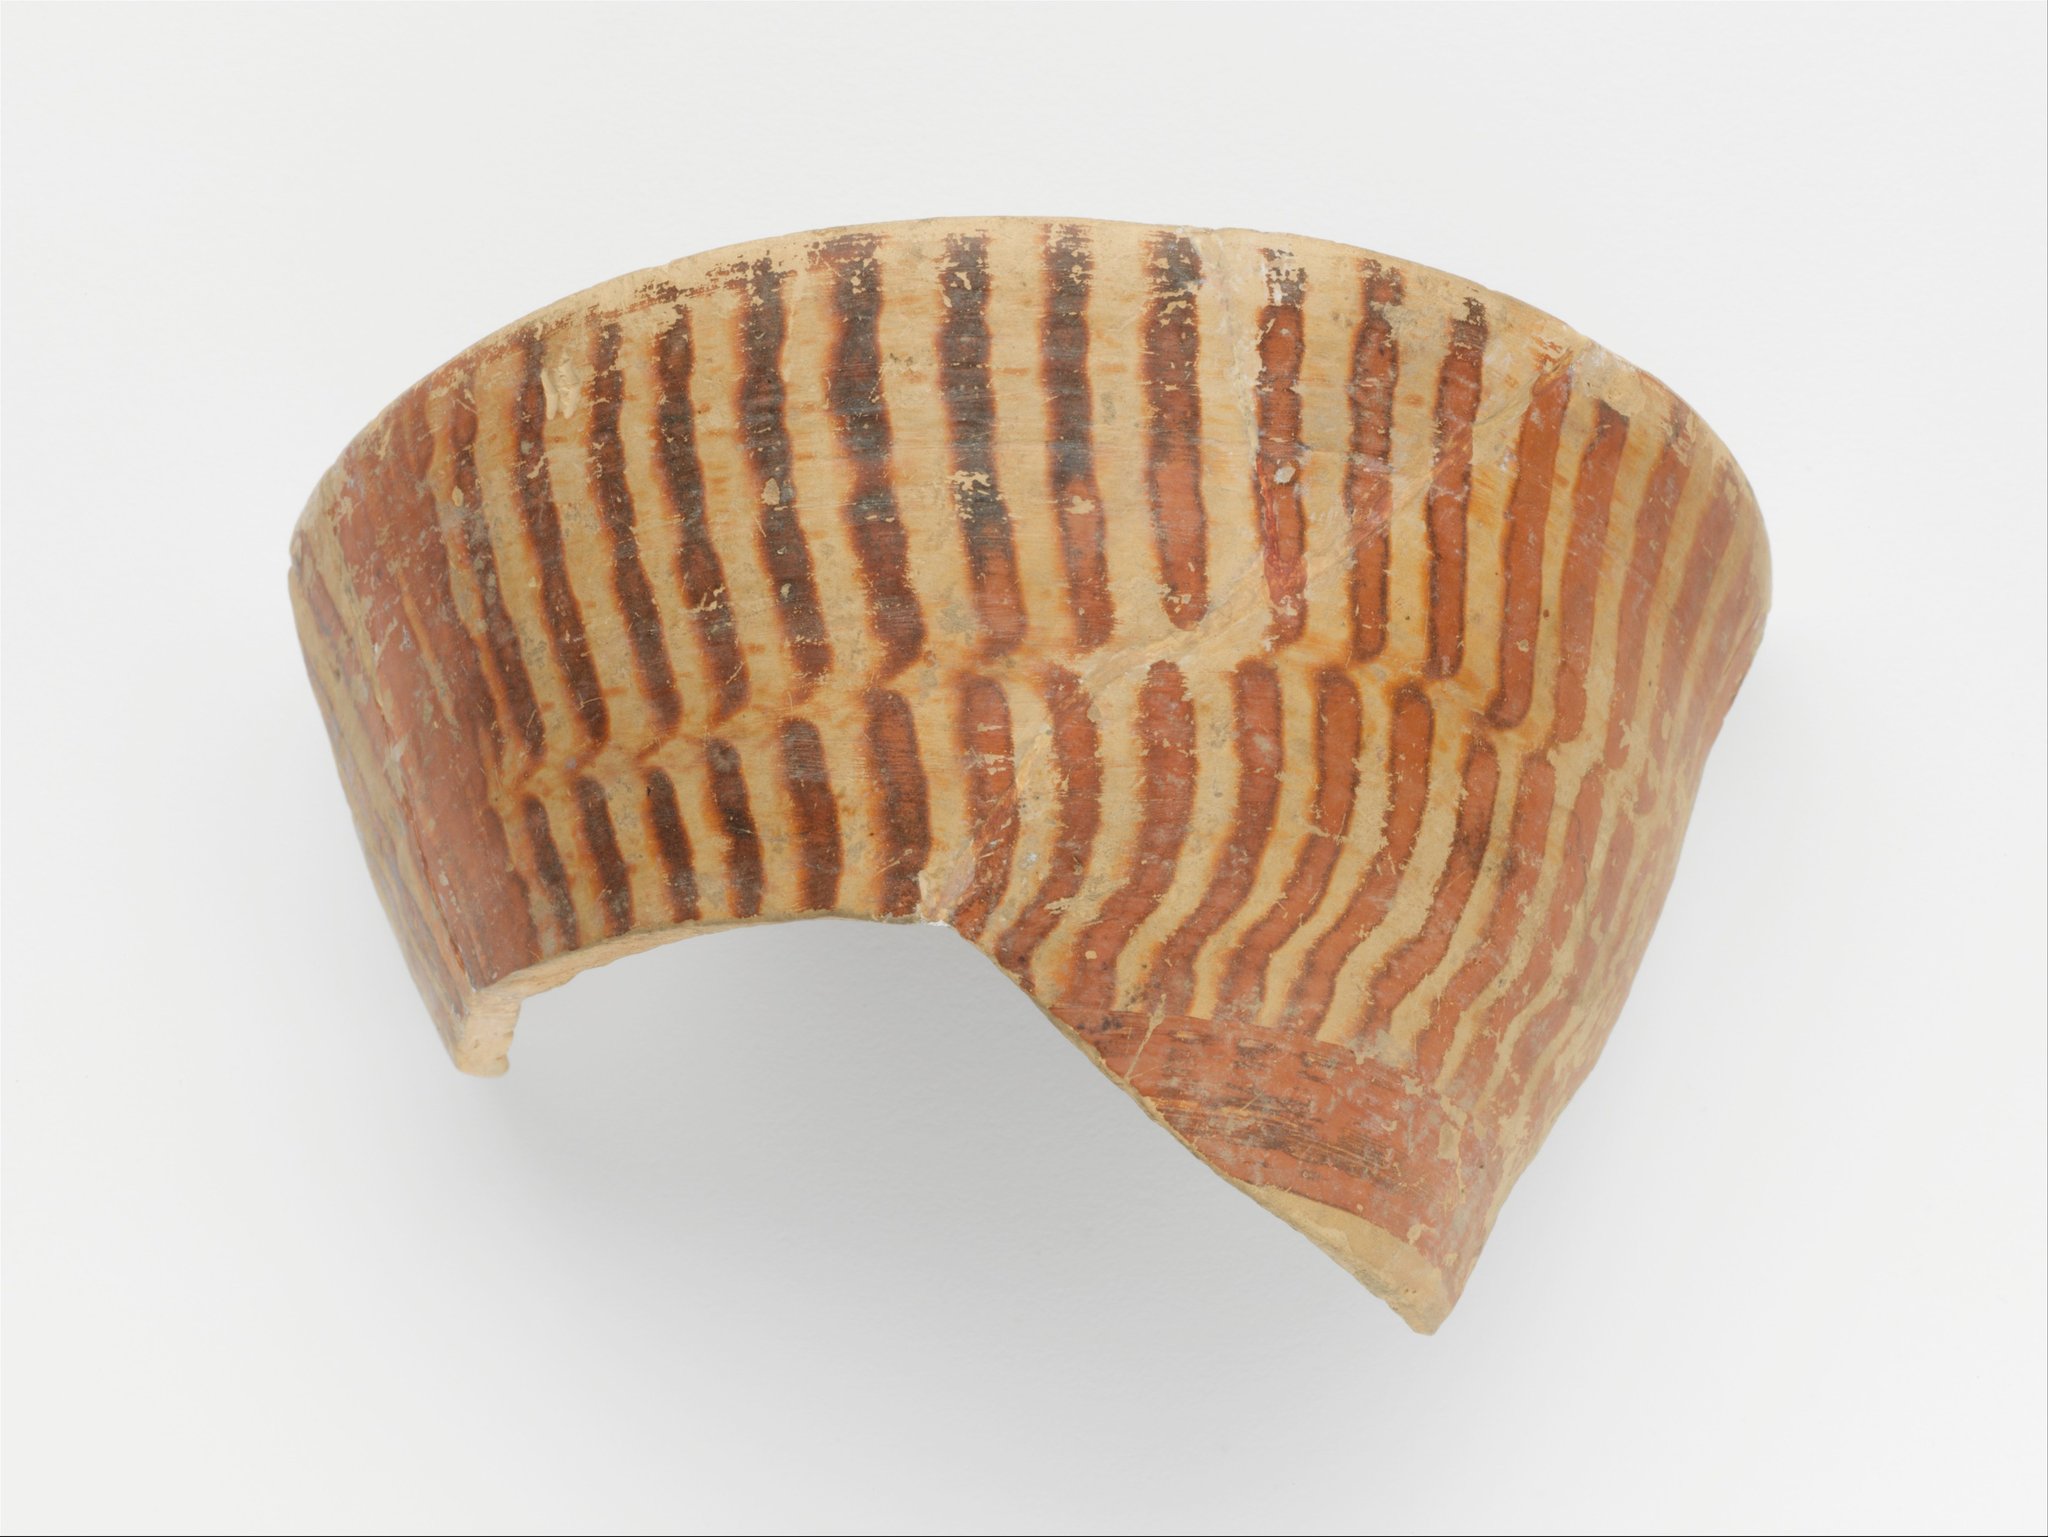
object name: cup, fragment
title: Terracotta rim and upper body fragment from a straight-sided cup with tortoiseshell ripple motif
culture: minoan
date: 1600-1525 BCE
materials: terracotta